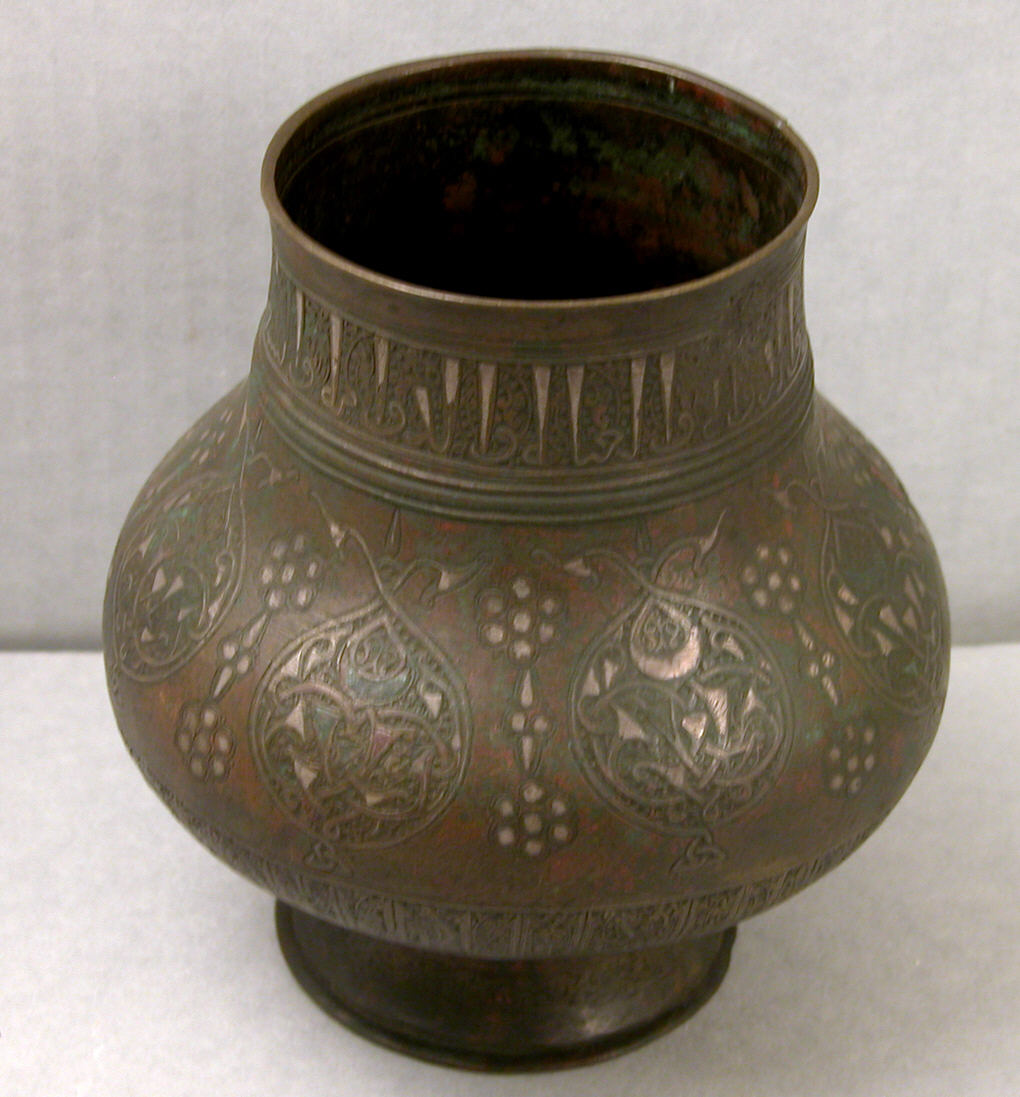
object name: vase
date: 1201-1233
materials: bronze, silver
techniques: engraving, inlay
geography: iran